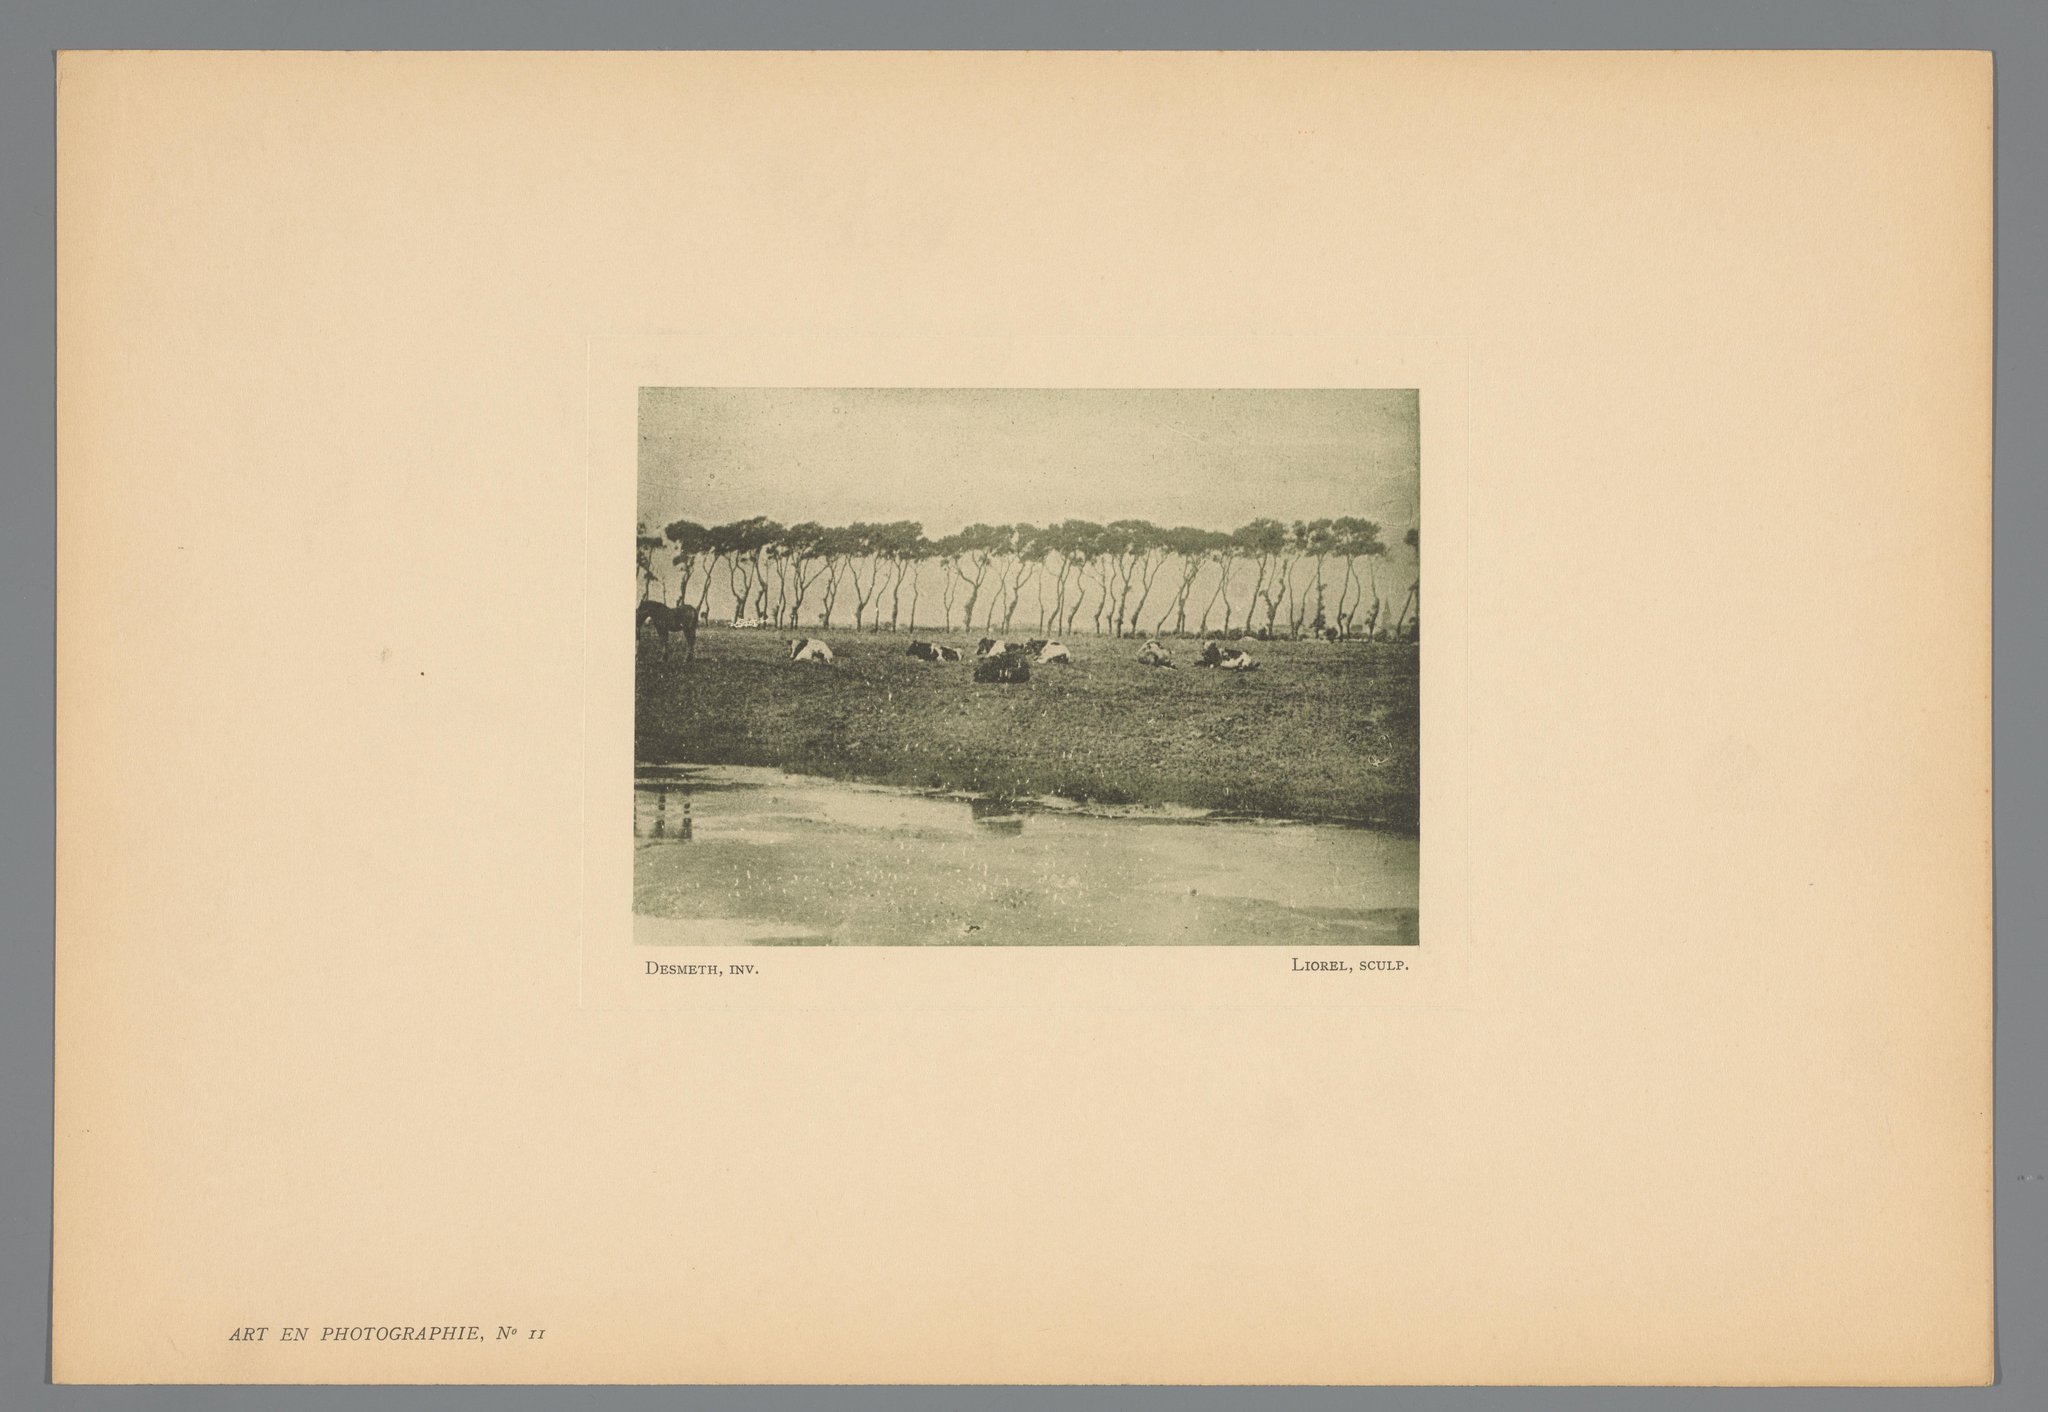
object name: photomechanical print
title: Koeien en een paard in een weiland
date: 1896-1901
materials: paper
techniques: photograph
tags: cow, meadow, pasture, horse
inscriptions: inscription: ‘ART EN PHOTOGRAPHIE, No 11’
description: Deze prent maakt deel uit van een omslag met 54 prenten op 52 bladen.